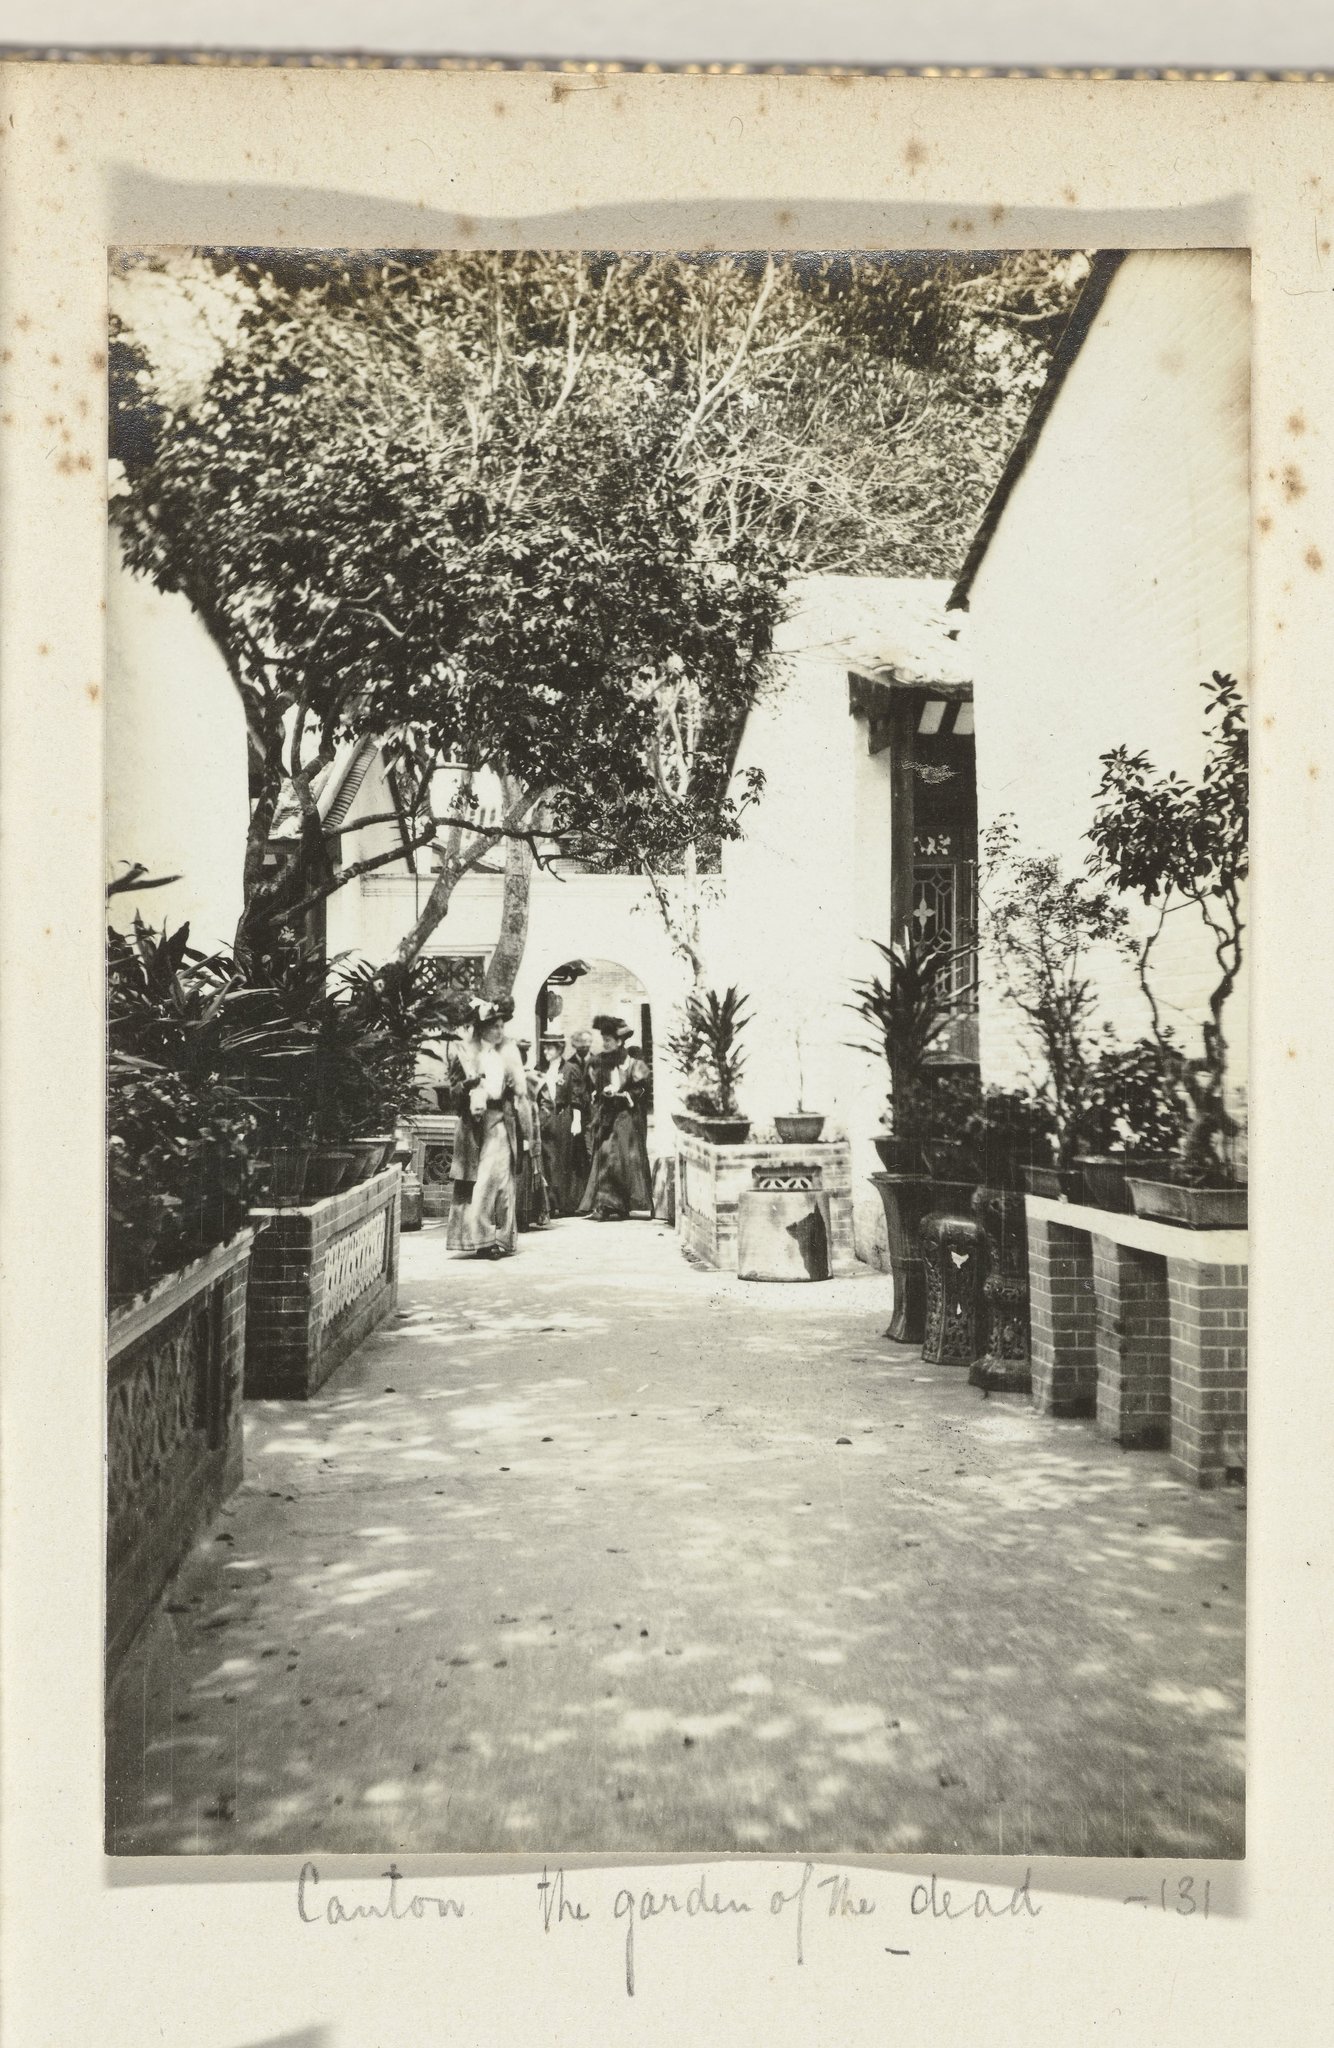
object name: photograph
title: Canton, the garden of the dead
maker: geldolph adriaan kessler (dolph)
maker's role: fotograaf, industrieel, voetballer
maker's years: 1884-1945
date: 1903-1908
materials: cardboard, photographic support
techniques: gelatin silver print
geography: guangdong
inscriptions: title: ‘Canton, the garden of the dead.’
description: Bezoek aan een begraafplaats in Kanton. Onderdeel van het fotoalbum van Dolph Kessler met opnamen die hij maakte tijdens zijn verblijf in Engeland en op een wereldreis die hij als secretaris van Henri Deterding (directeur Koninklijke Olie) ondernam naar Nederlands-Indië, Japan, China en de Verenigde Staten, tussen 1906 en 1908.